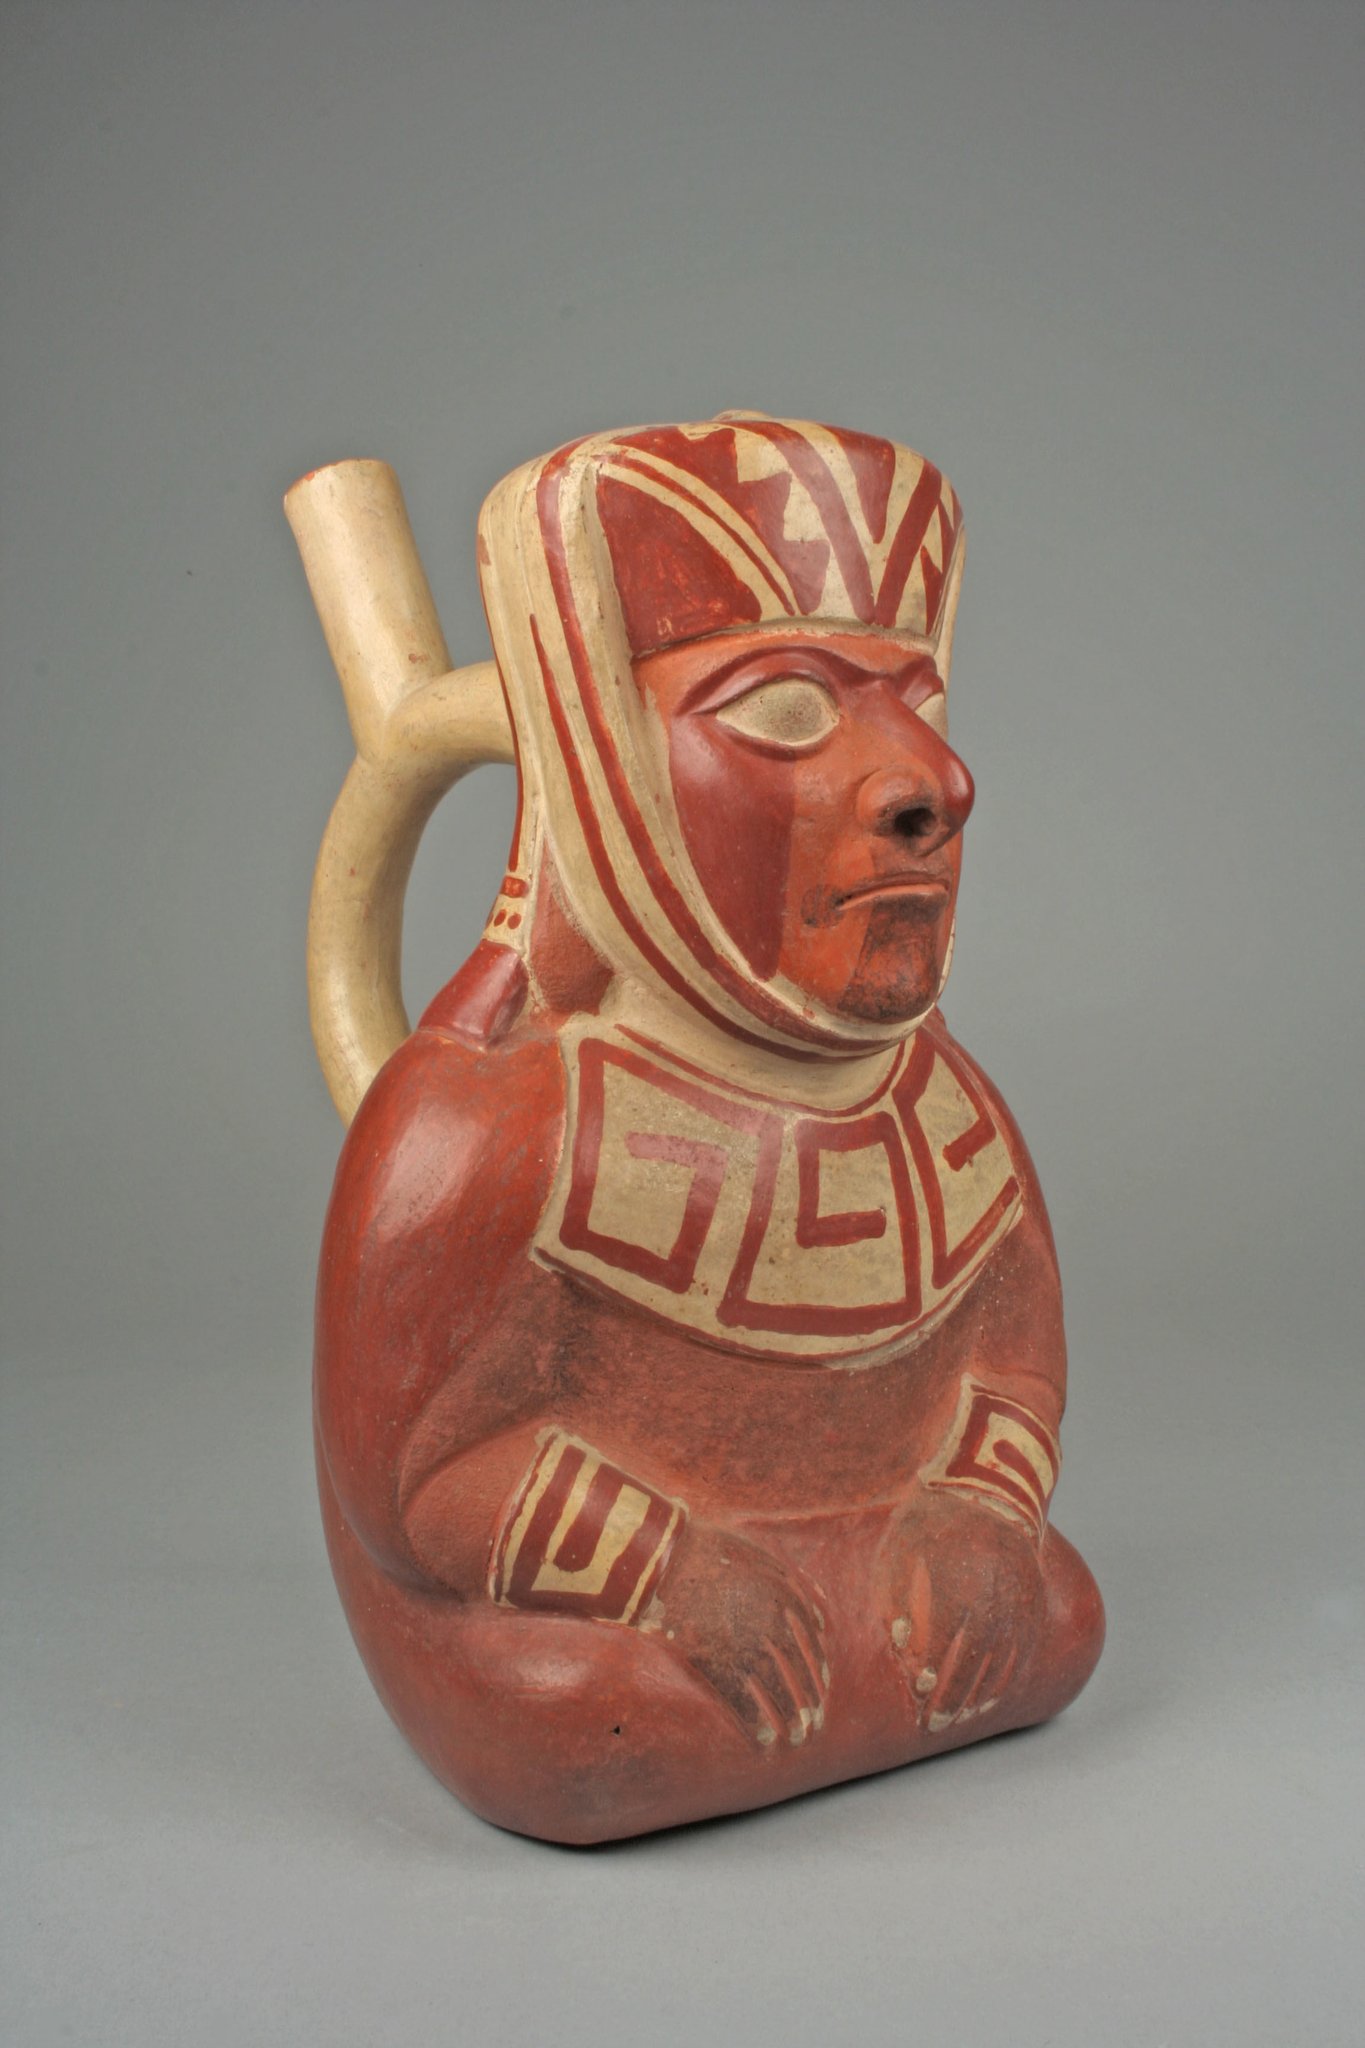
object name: bottle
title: Stirrup spout bottle with dignitary figure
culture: moche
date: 201-500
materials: ceramic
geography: peru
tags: human figures